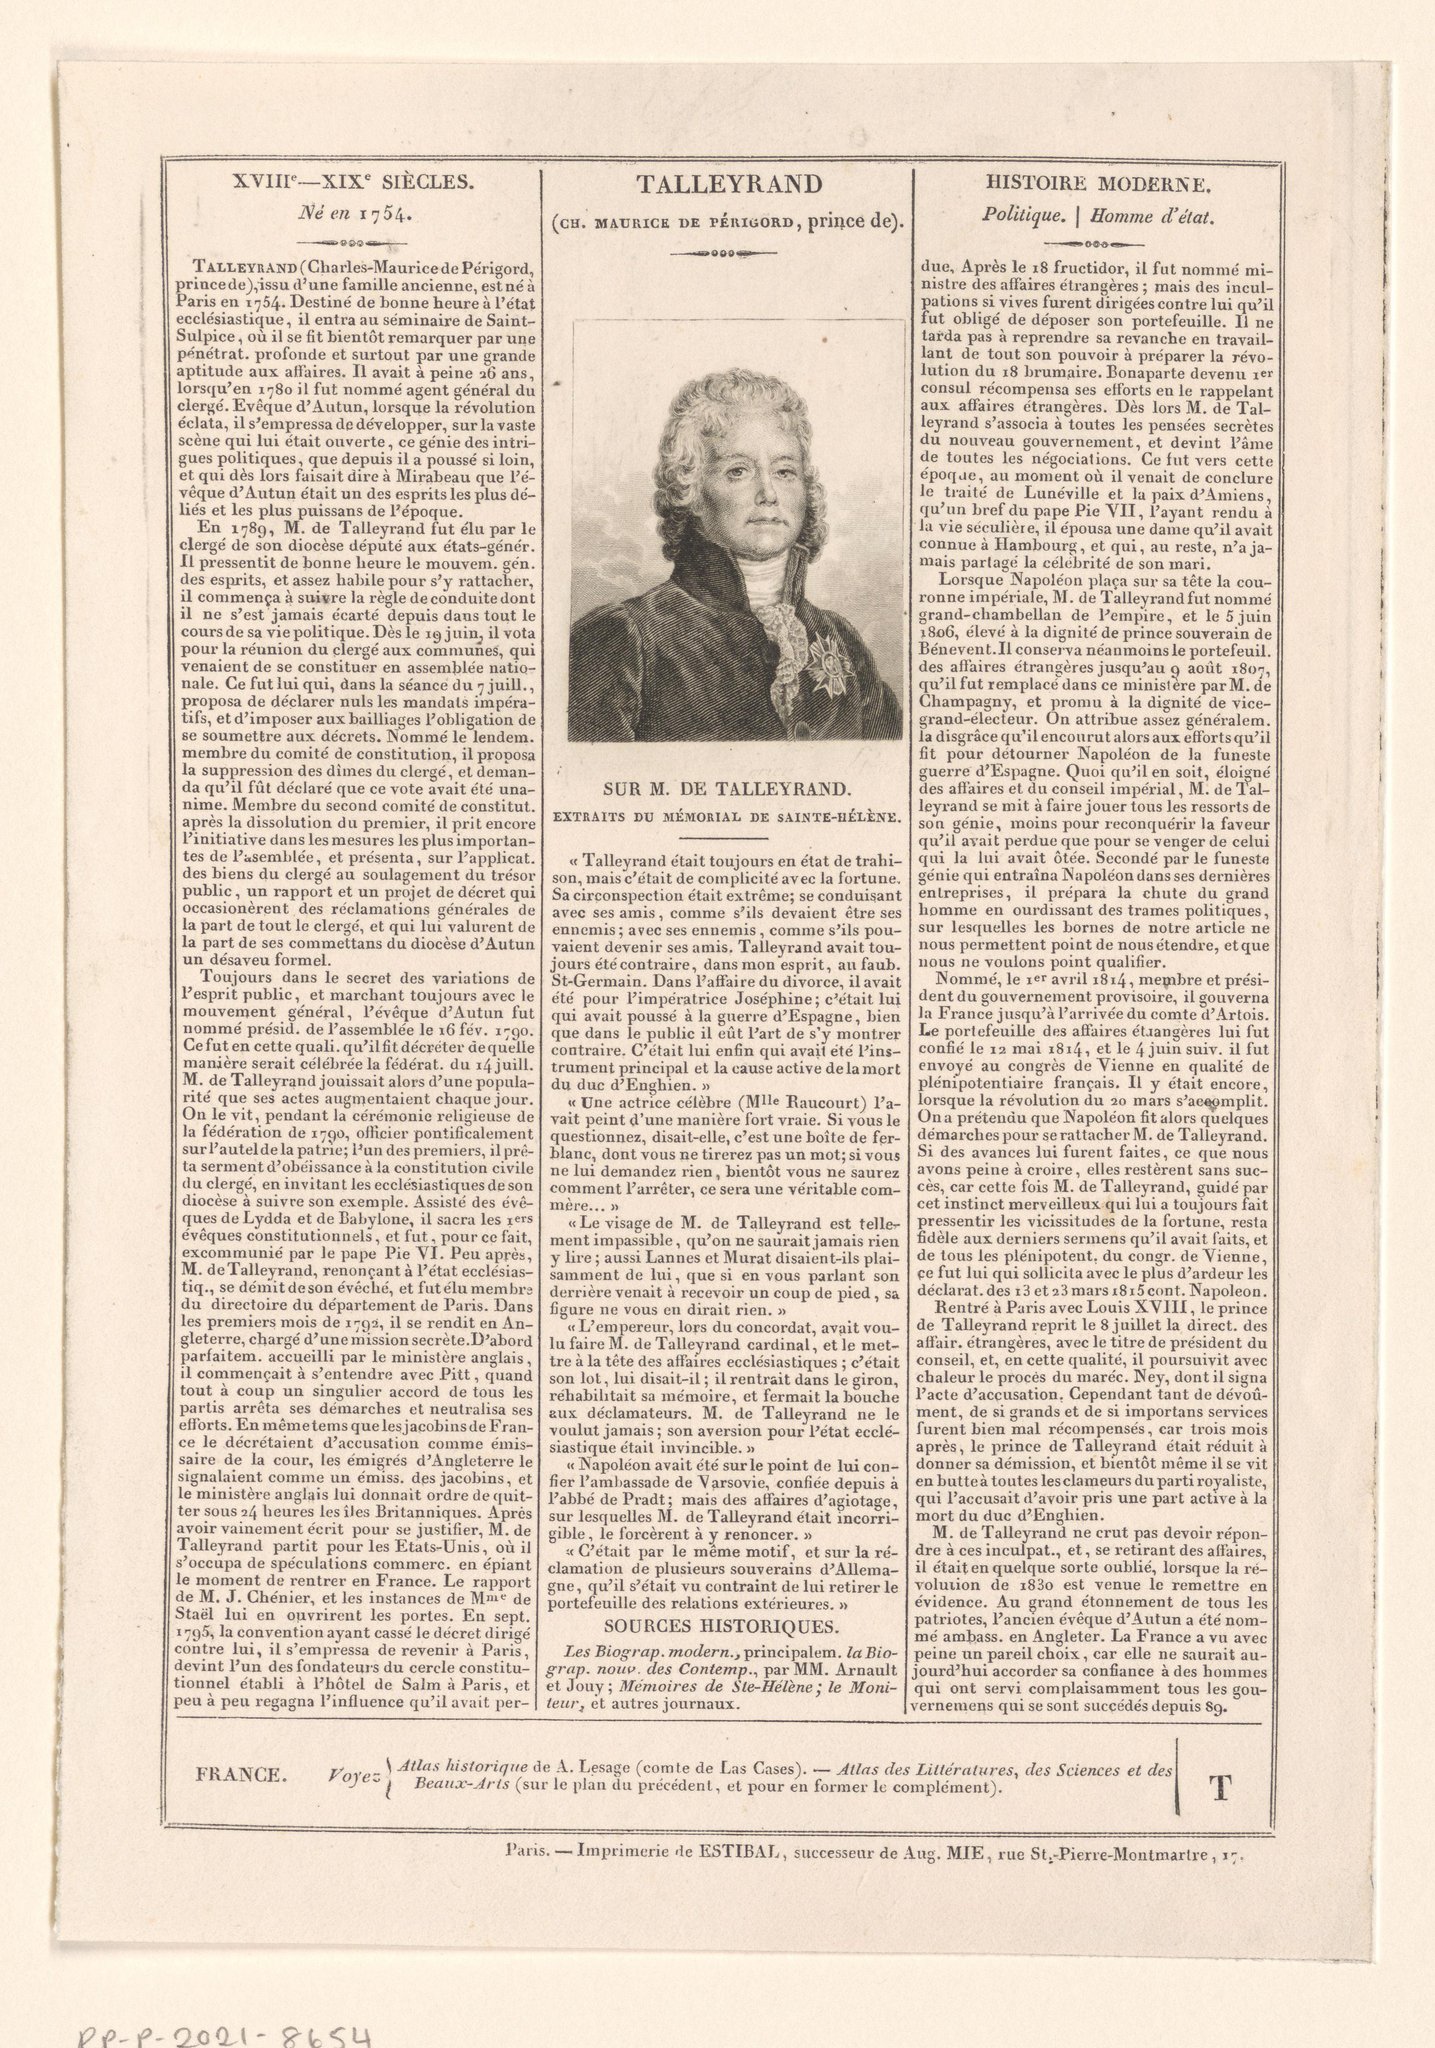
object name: print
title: Portret van Charles Maurice de Talleyrand-Périgord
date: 1830-1849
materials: paper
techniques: etching, letterpress printing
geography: paris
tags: paris, politician, charles maurice hertog van talleyrand-périgord, historical persons, politician, e.g. party leader